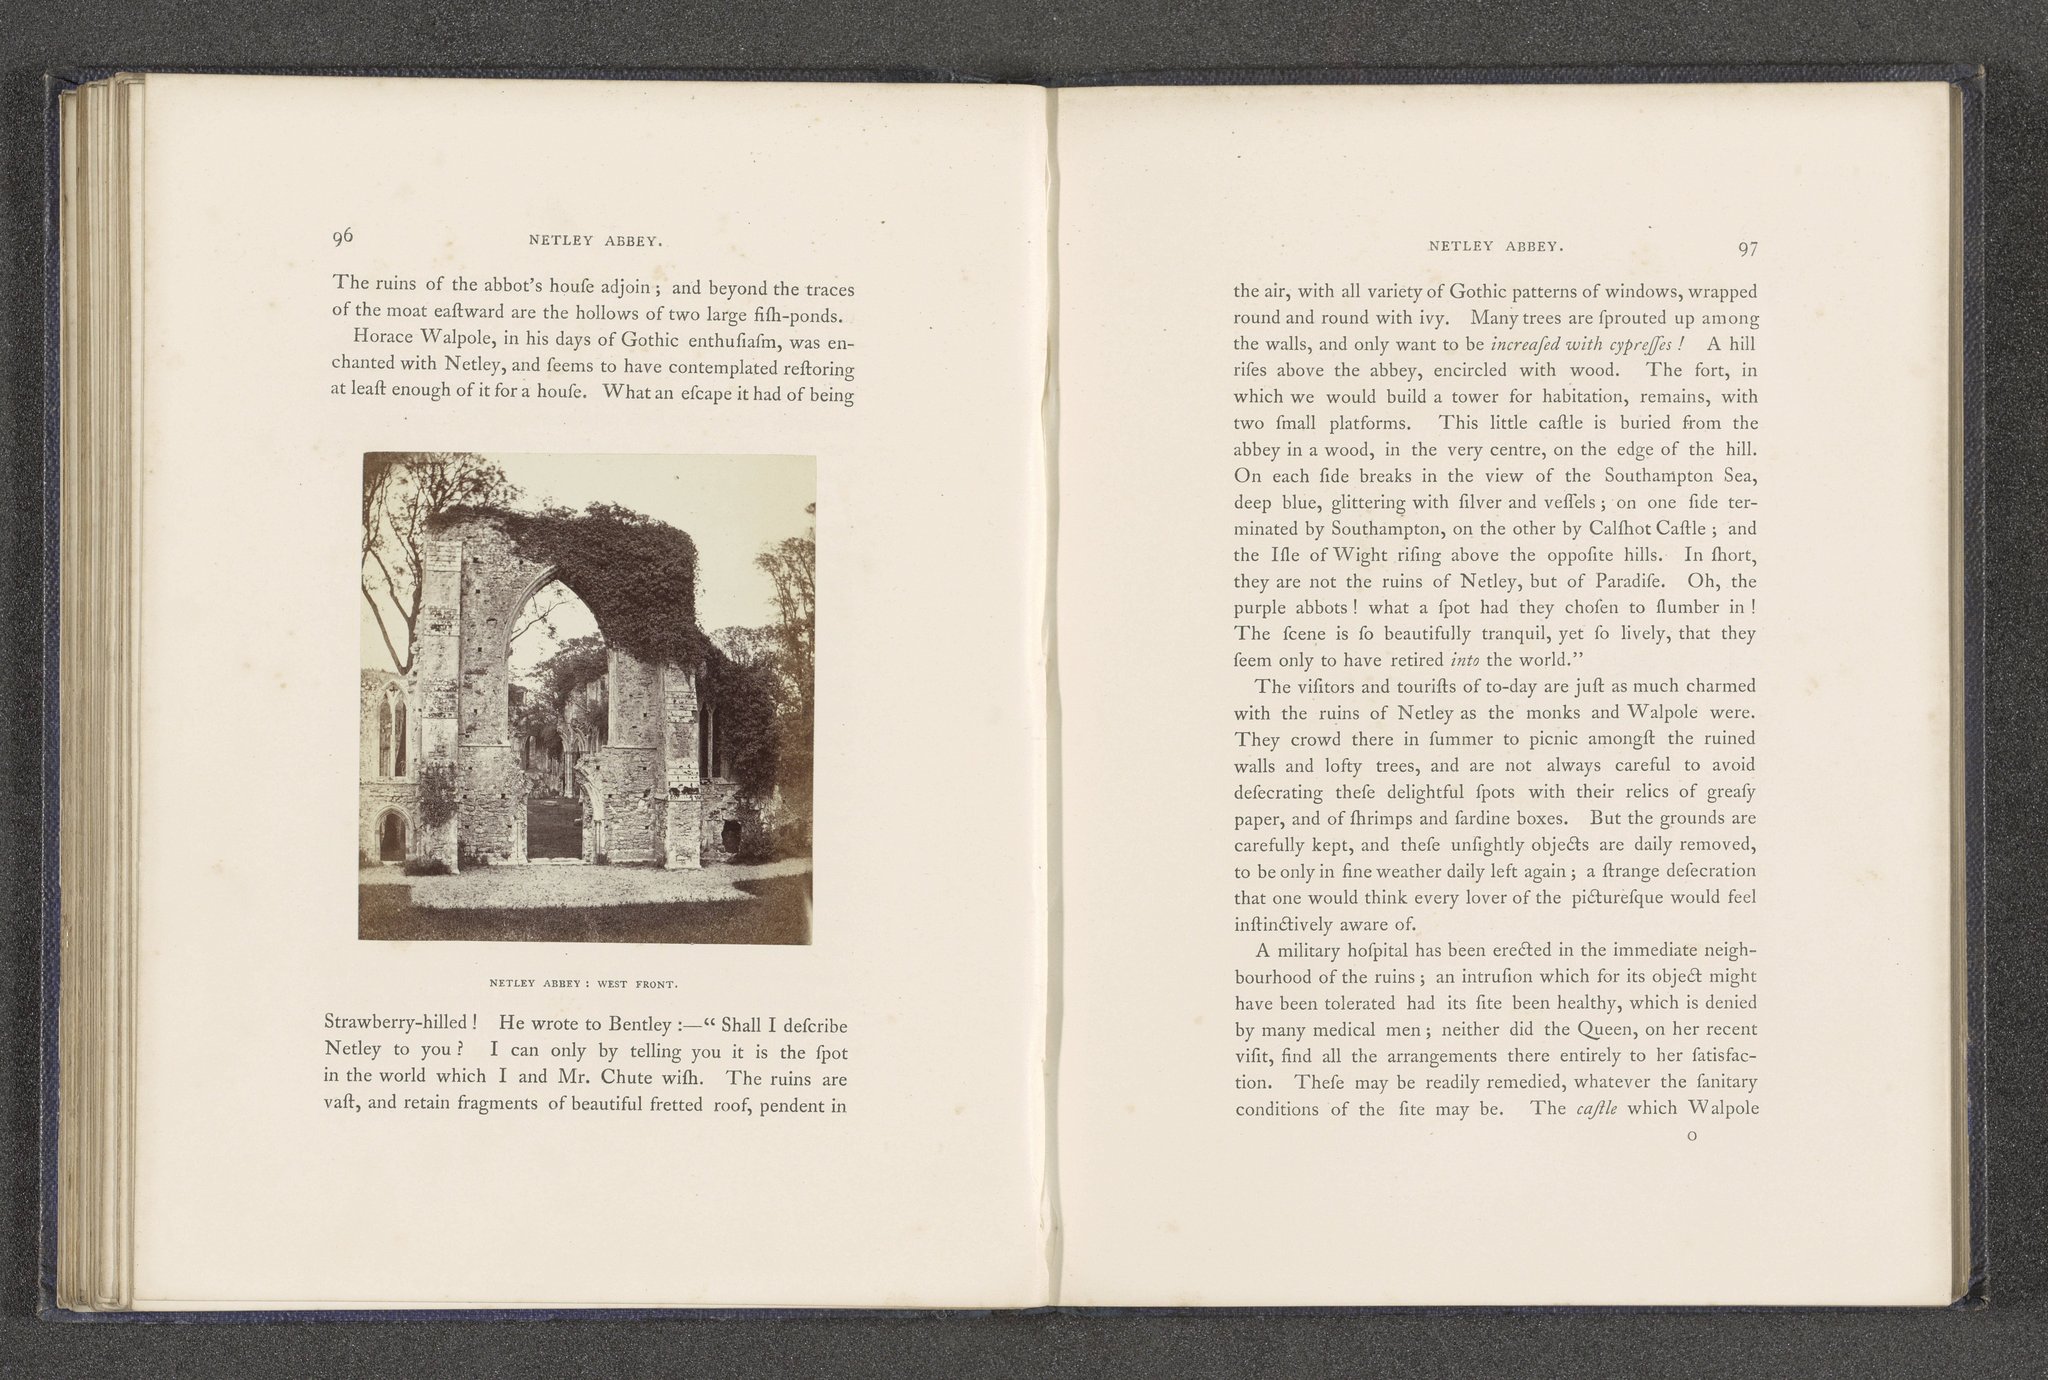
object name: page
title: Netley Abbey : West Front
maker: stephen thompson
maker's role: fotograaf, schrijver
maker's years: 1831-1893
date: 1854-1864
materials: photographic support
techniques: albumen print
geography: netley abbey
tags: ruin of church, monastery, etc.